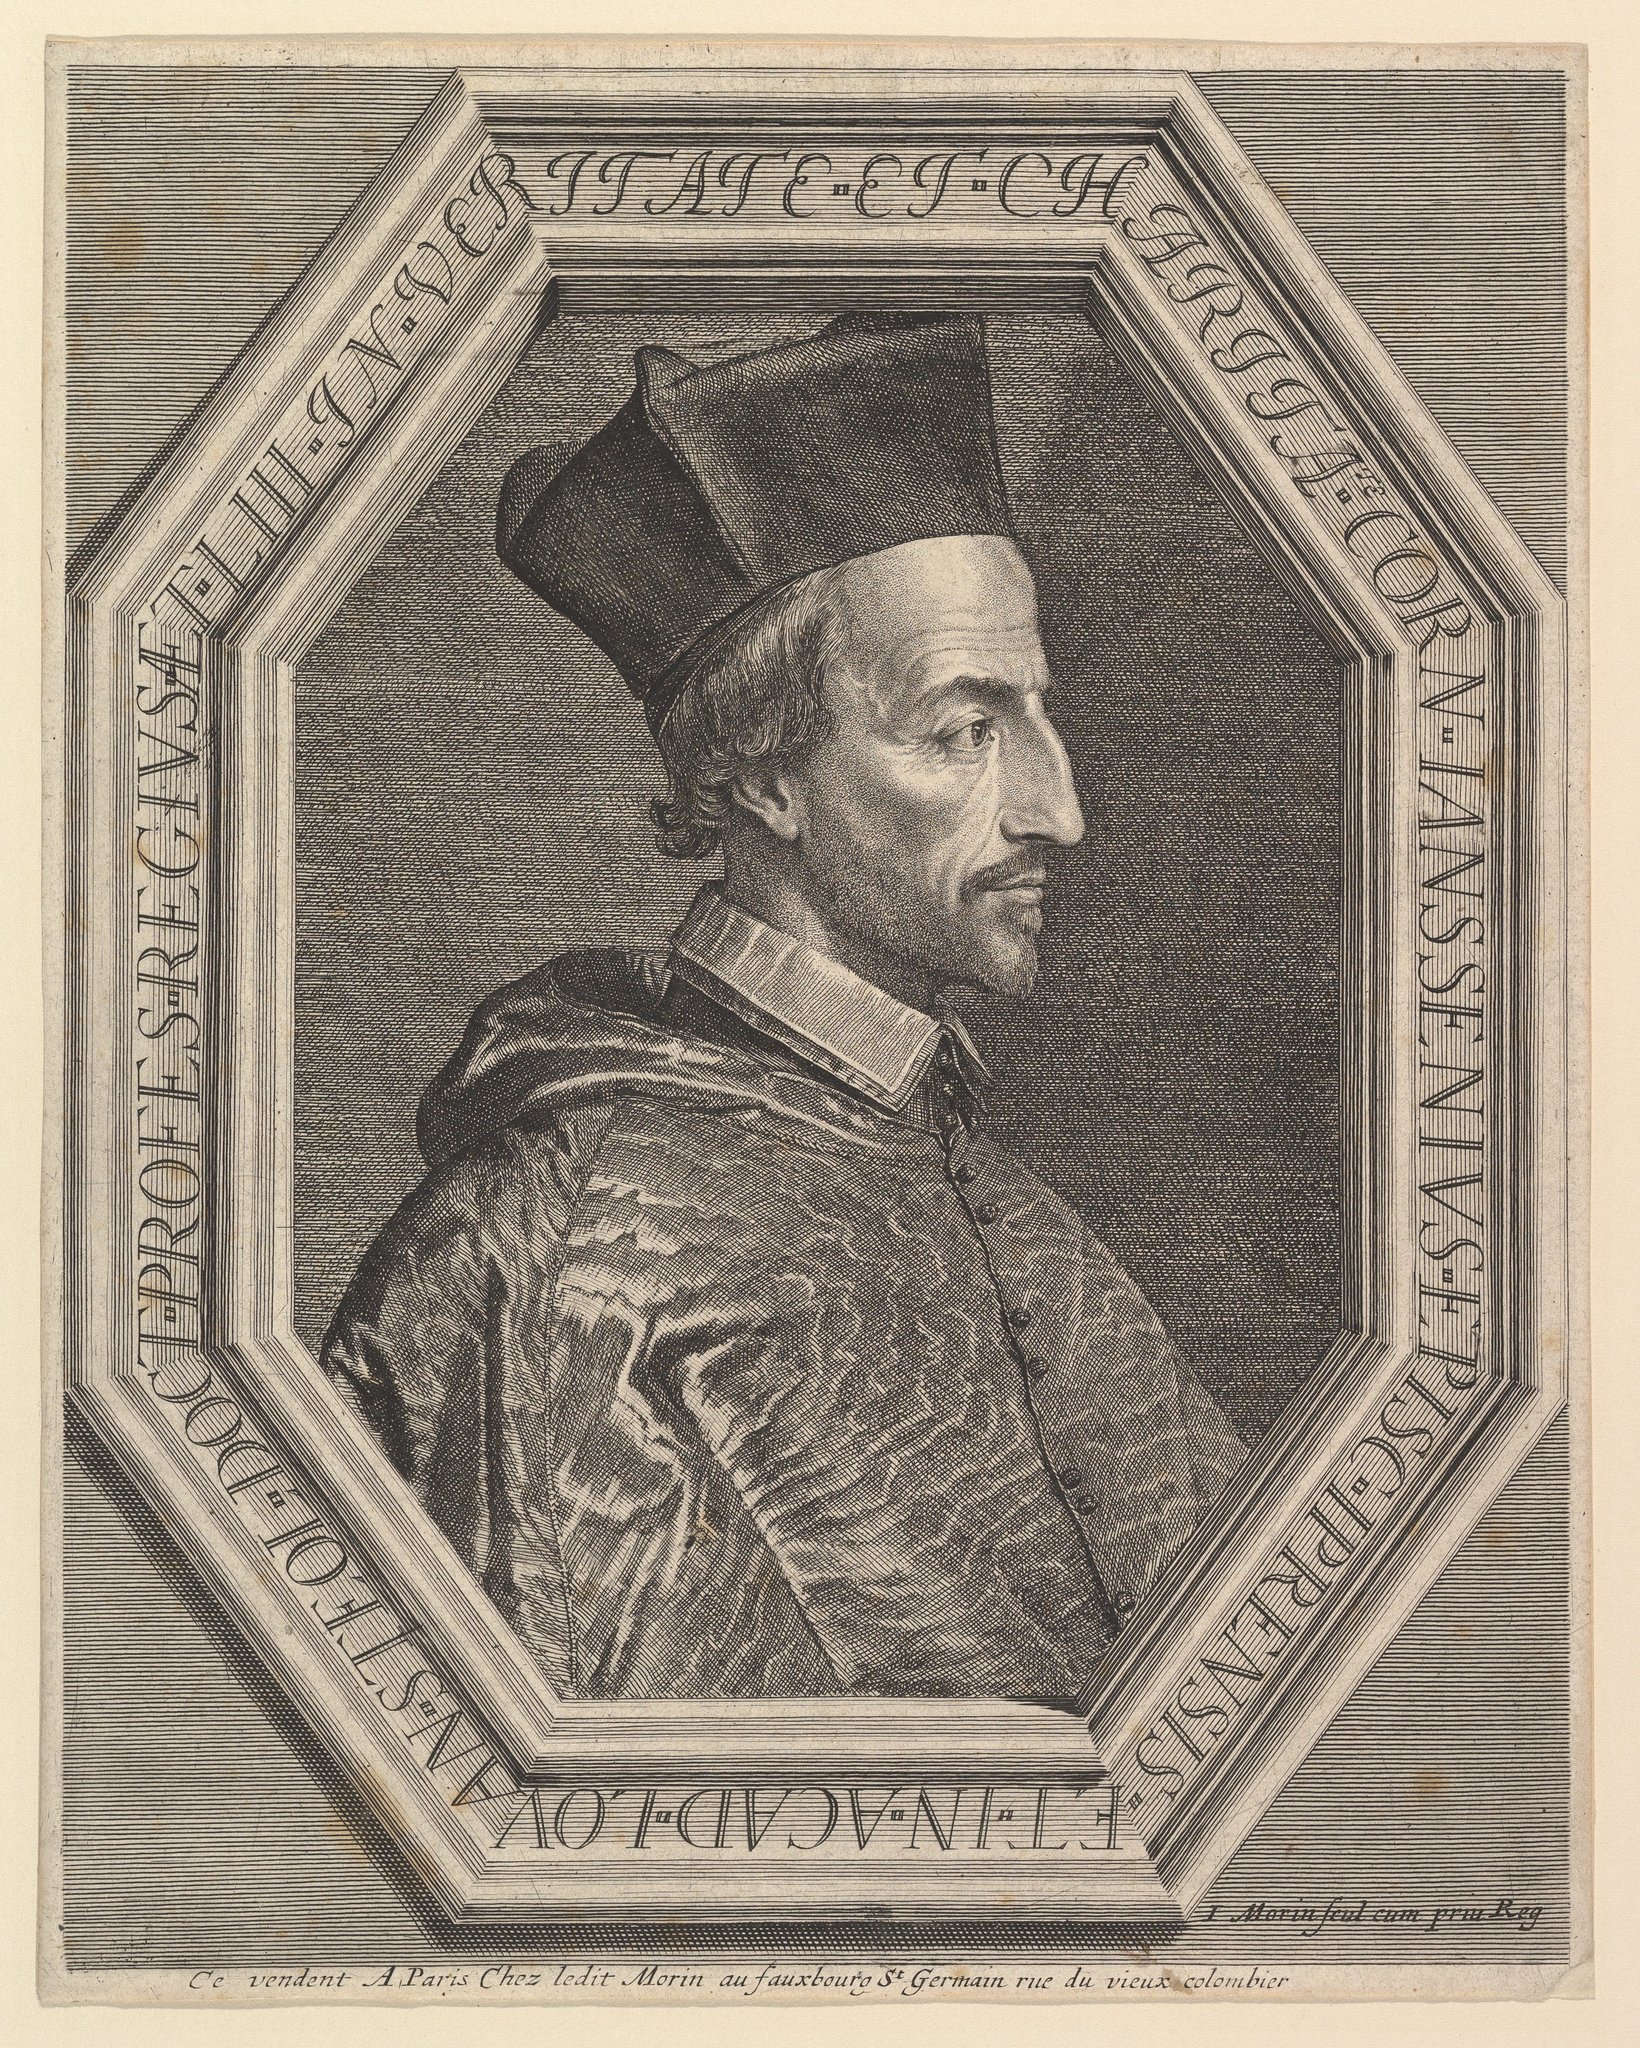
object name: print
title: Jansenius, eveque d'Ypres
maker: jean morin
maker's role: artist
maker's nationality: french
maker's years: 1605-1650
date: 1605-1650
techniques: etching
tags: men,portraits